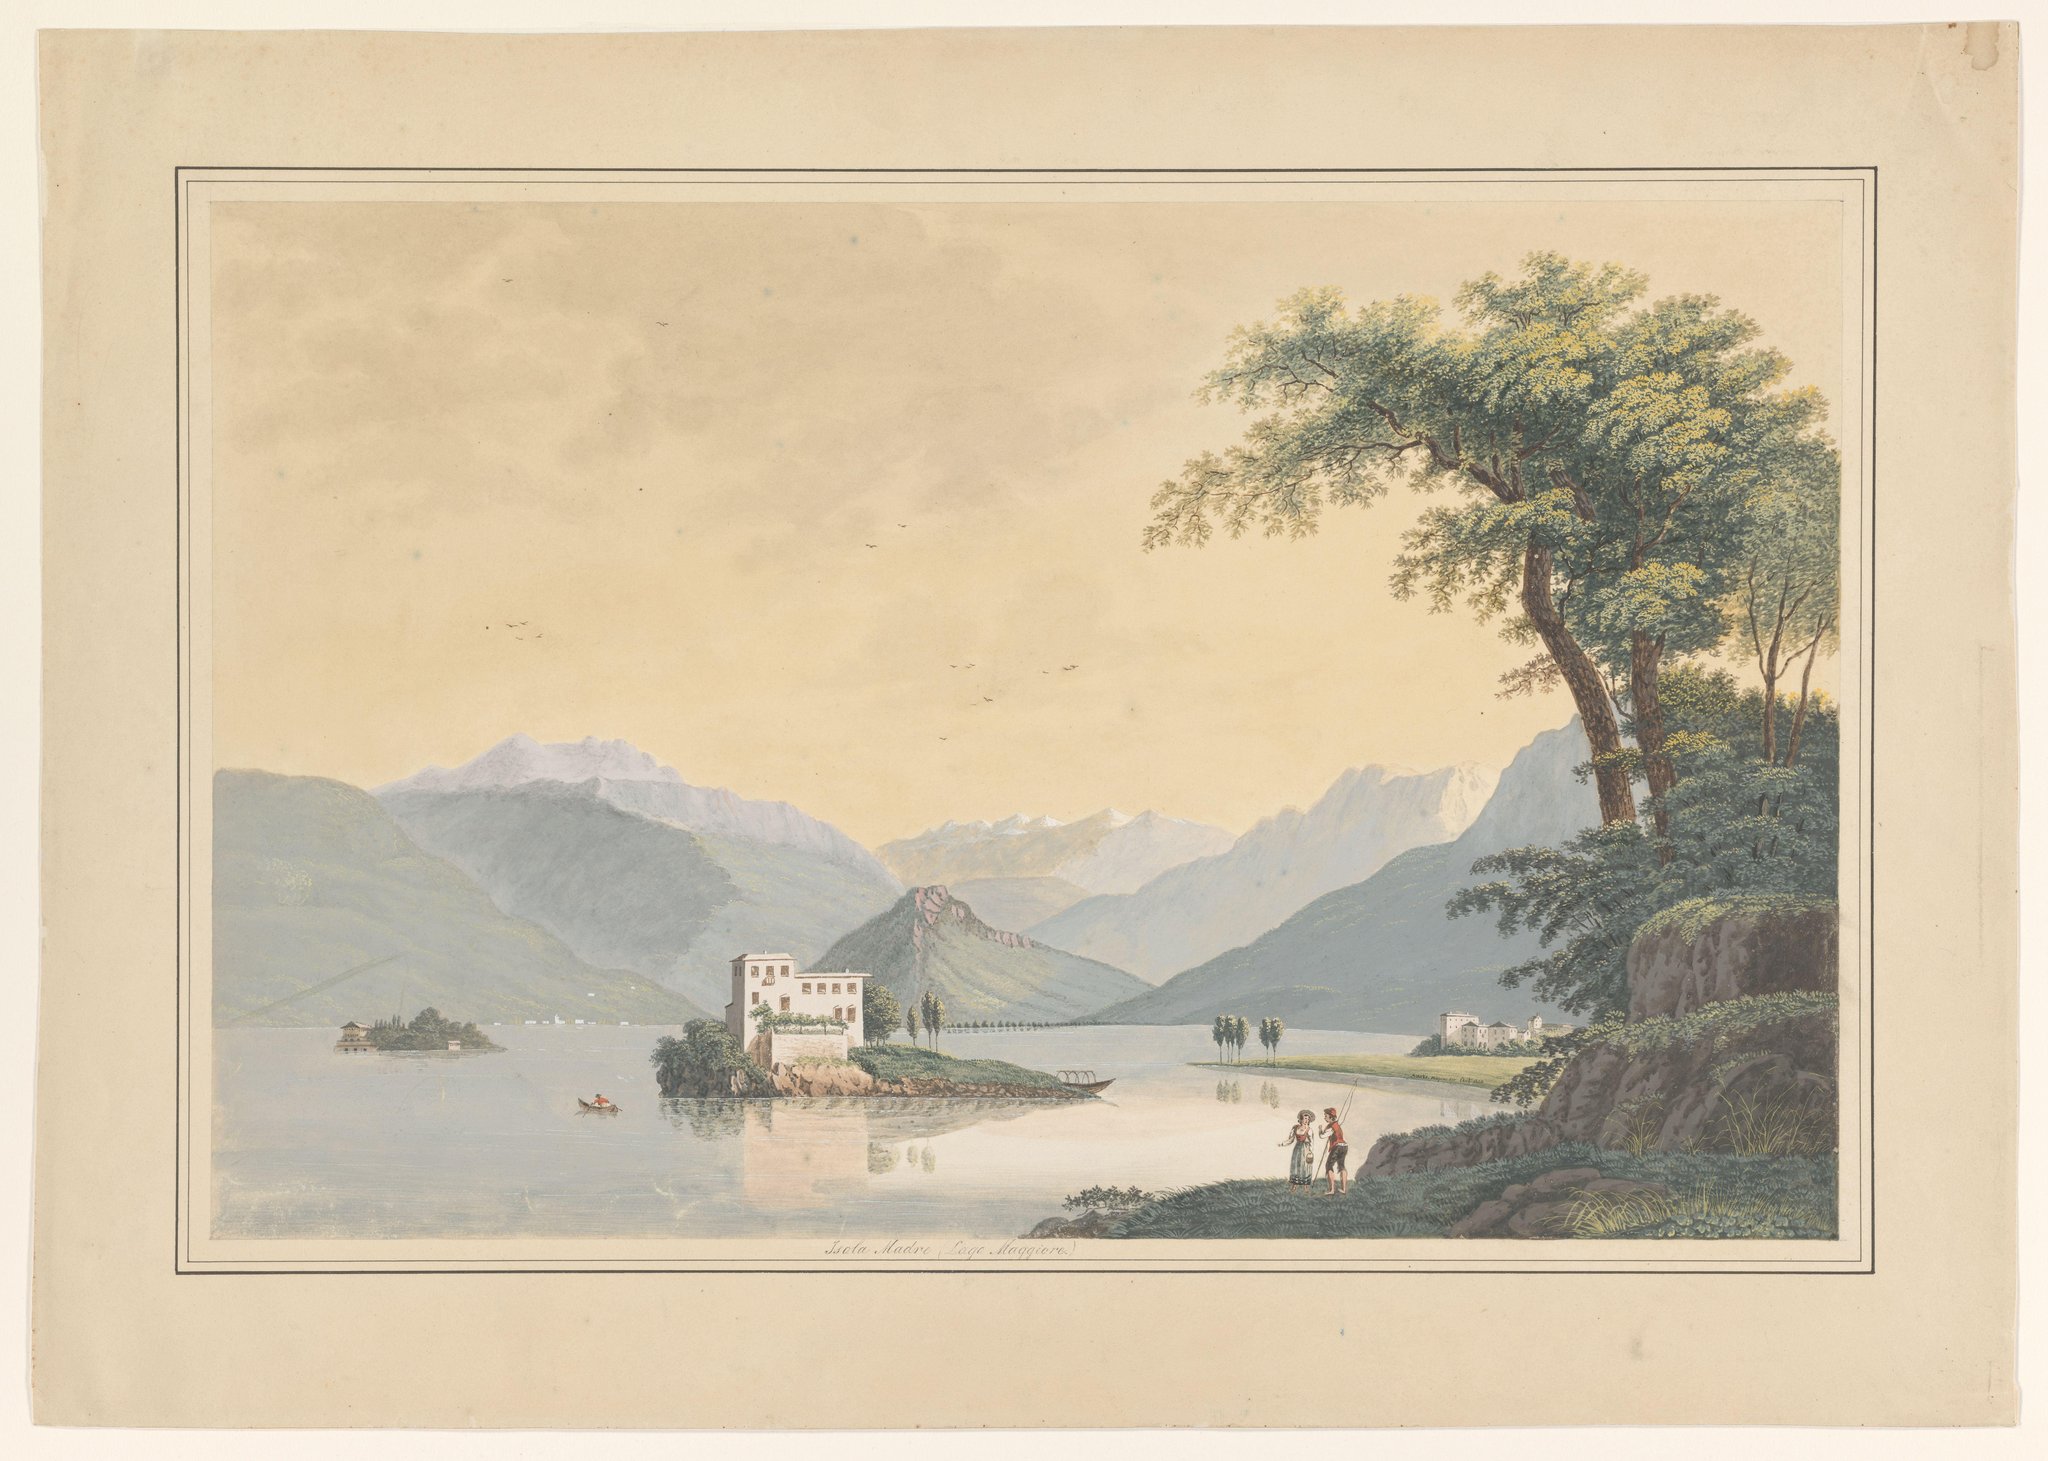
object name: drawing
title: Gezicht op de Isola Madre in de Lago Maggiore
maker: johannes josephus aarts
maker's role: draughtsman, print maker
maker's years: 1871-1934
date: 1828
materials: paper, watercolor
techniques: brush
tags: city-view, and landscape with man-made constructions, italy